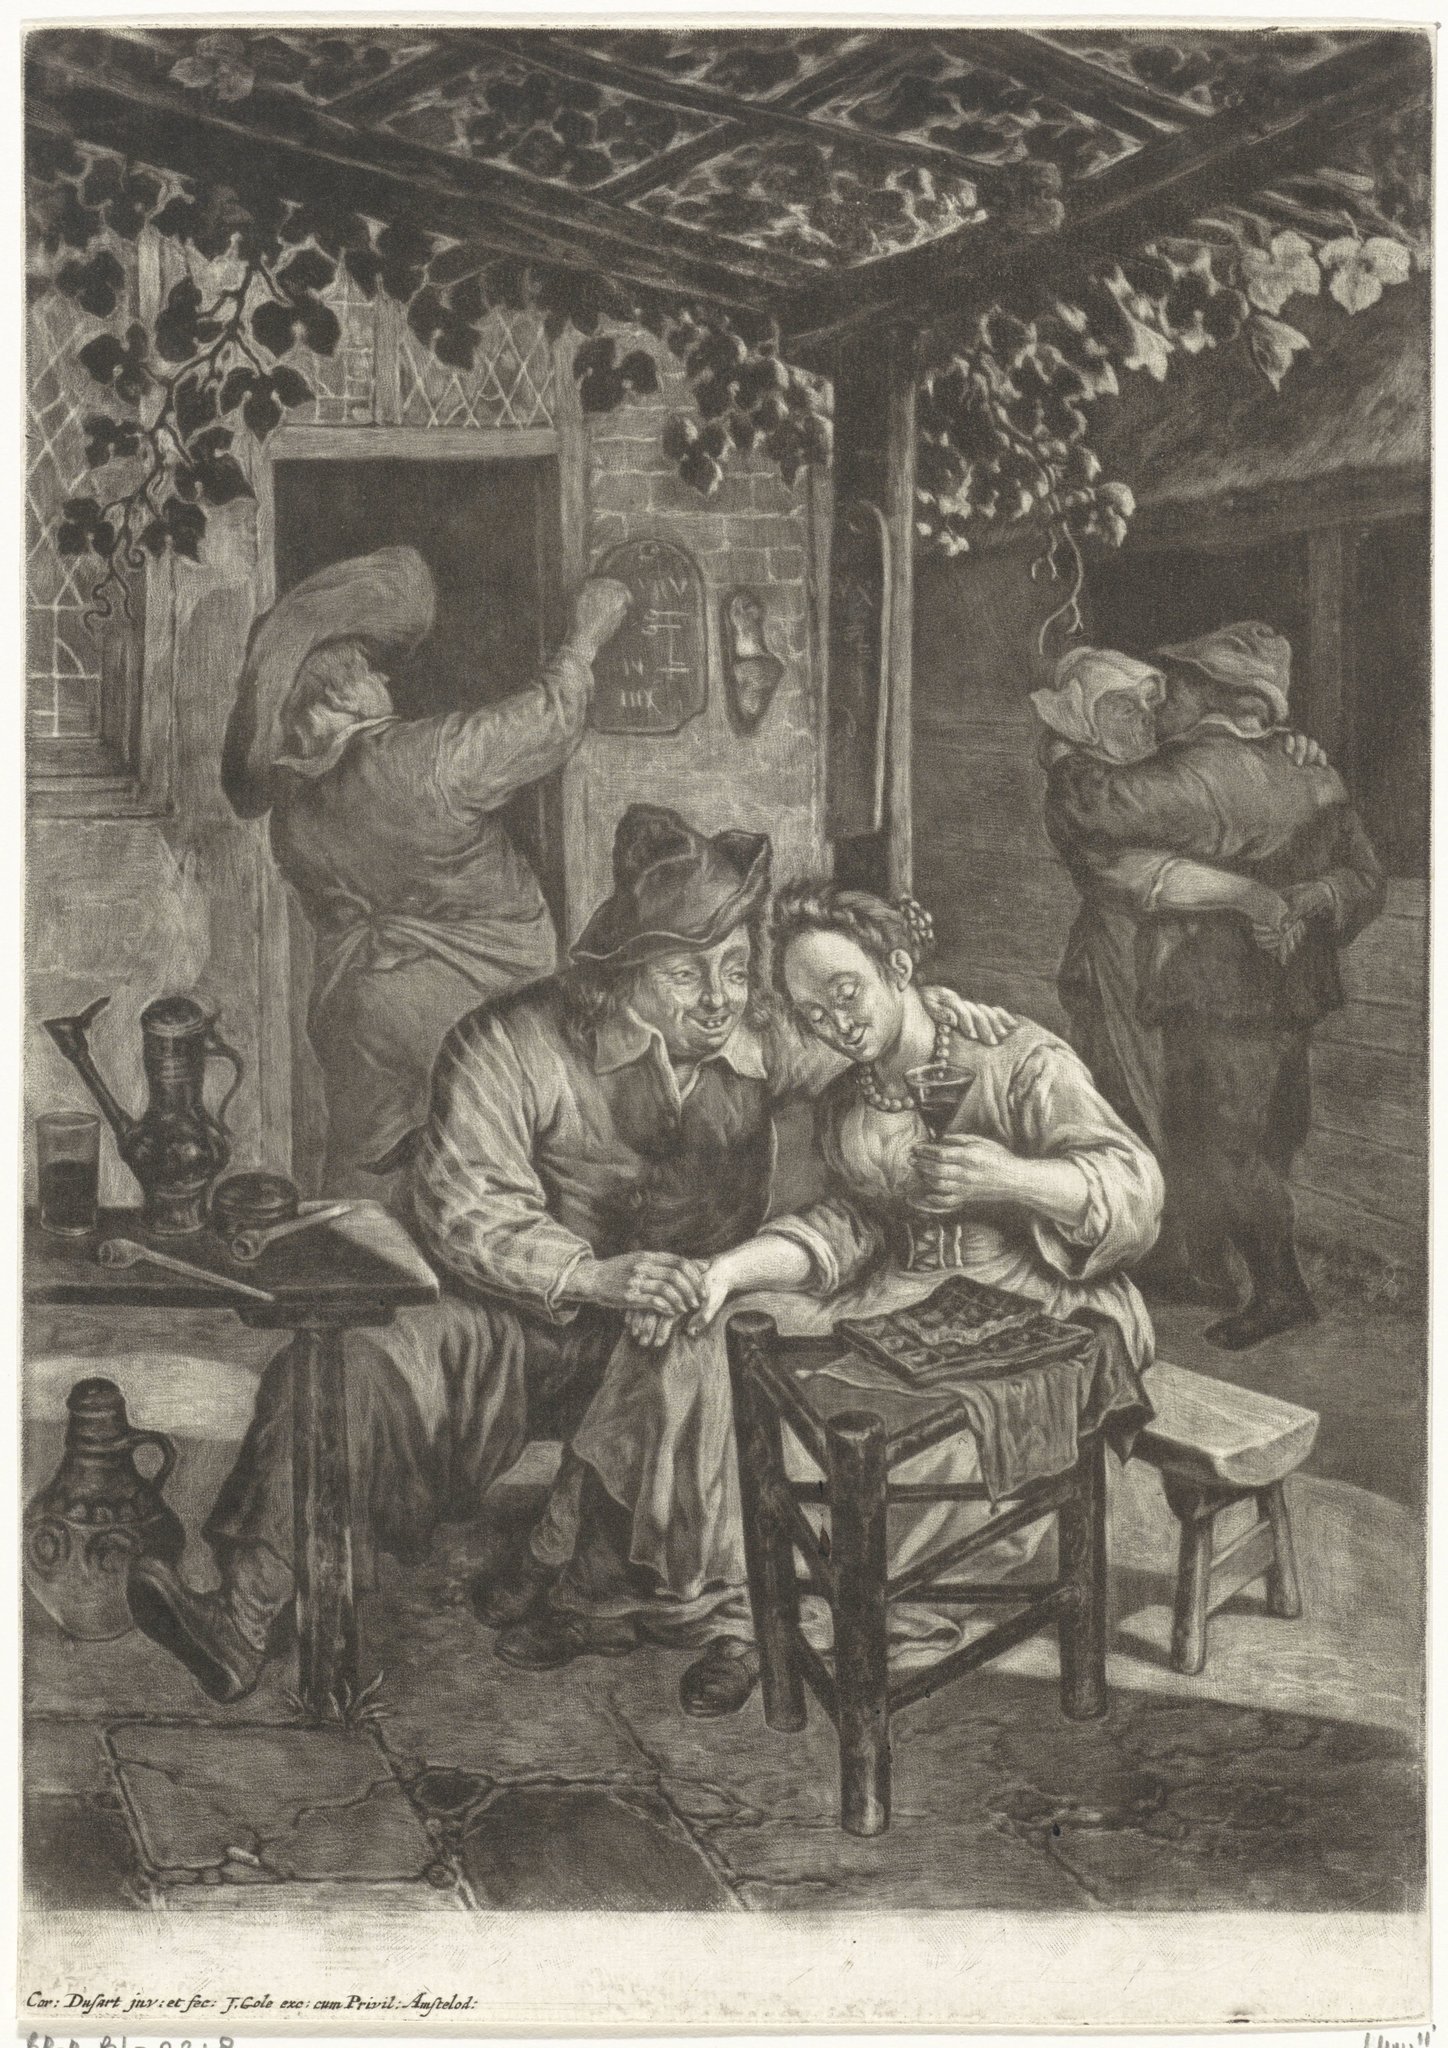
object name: print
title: De leeftijden van de mens, "Les Quatres Ages De la vie humaine"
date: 1680-1704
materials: paper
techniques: engraving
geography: amsterdam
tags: youth, adolescent, human life divided into stages, e.g. three, four, seven, twelve stages (with number), terrace, couple of lovers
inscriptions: collector's mark: Lugt 2228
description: Op een terras voor een herberg onder een pergola zit een jong liefdespaar in een intieme houding bij een tafel. Ze eten wafels en drinken wijn en bier. Op de achtergrond een tweede liefdespaar in een omhelzing. De prent is onderdeel van een reeks van vier prenten over de leeftijden van de mens.